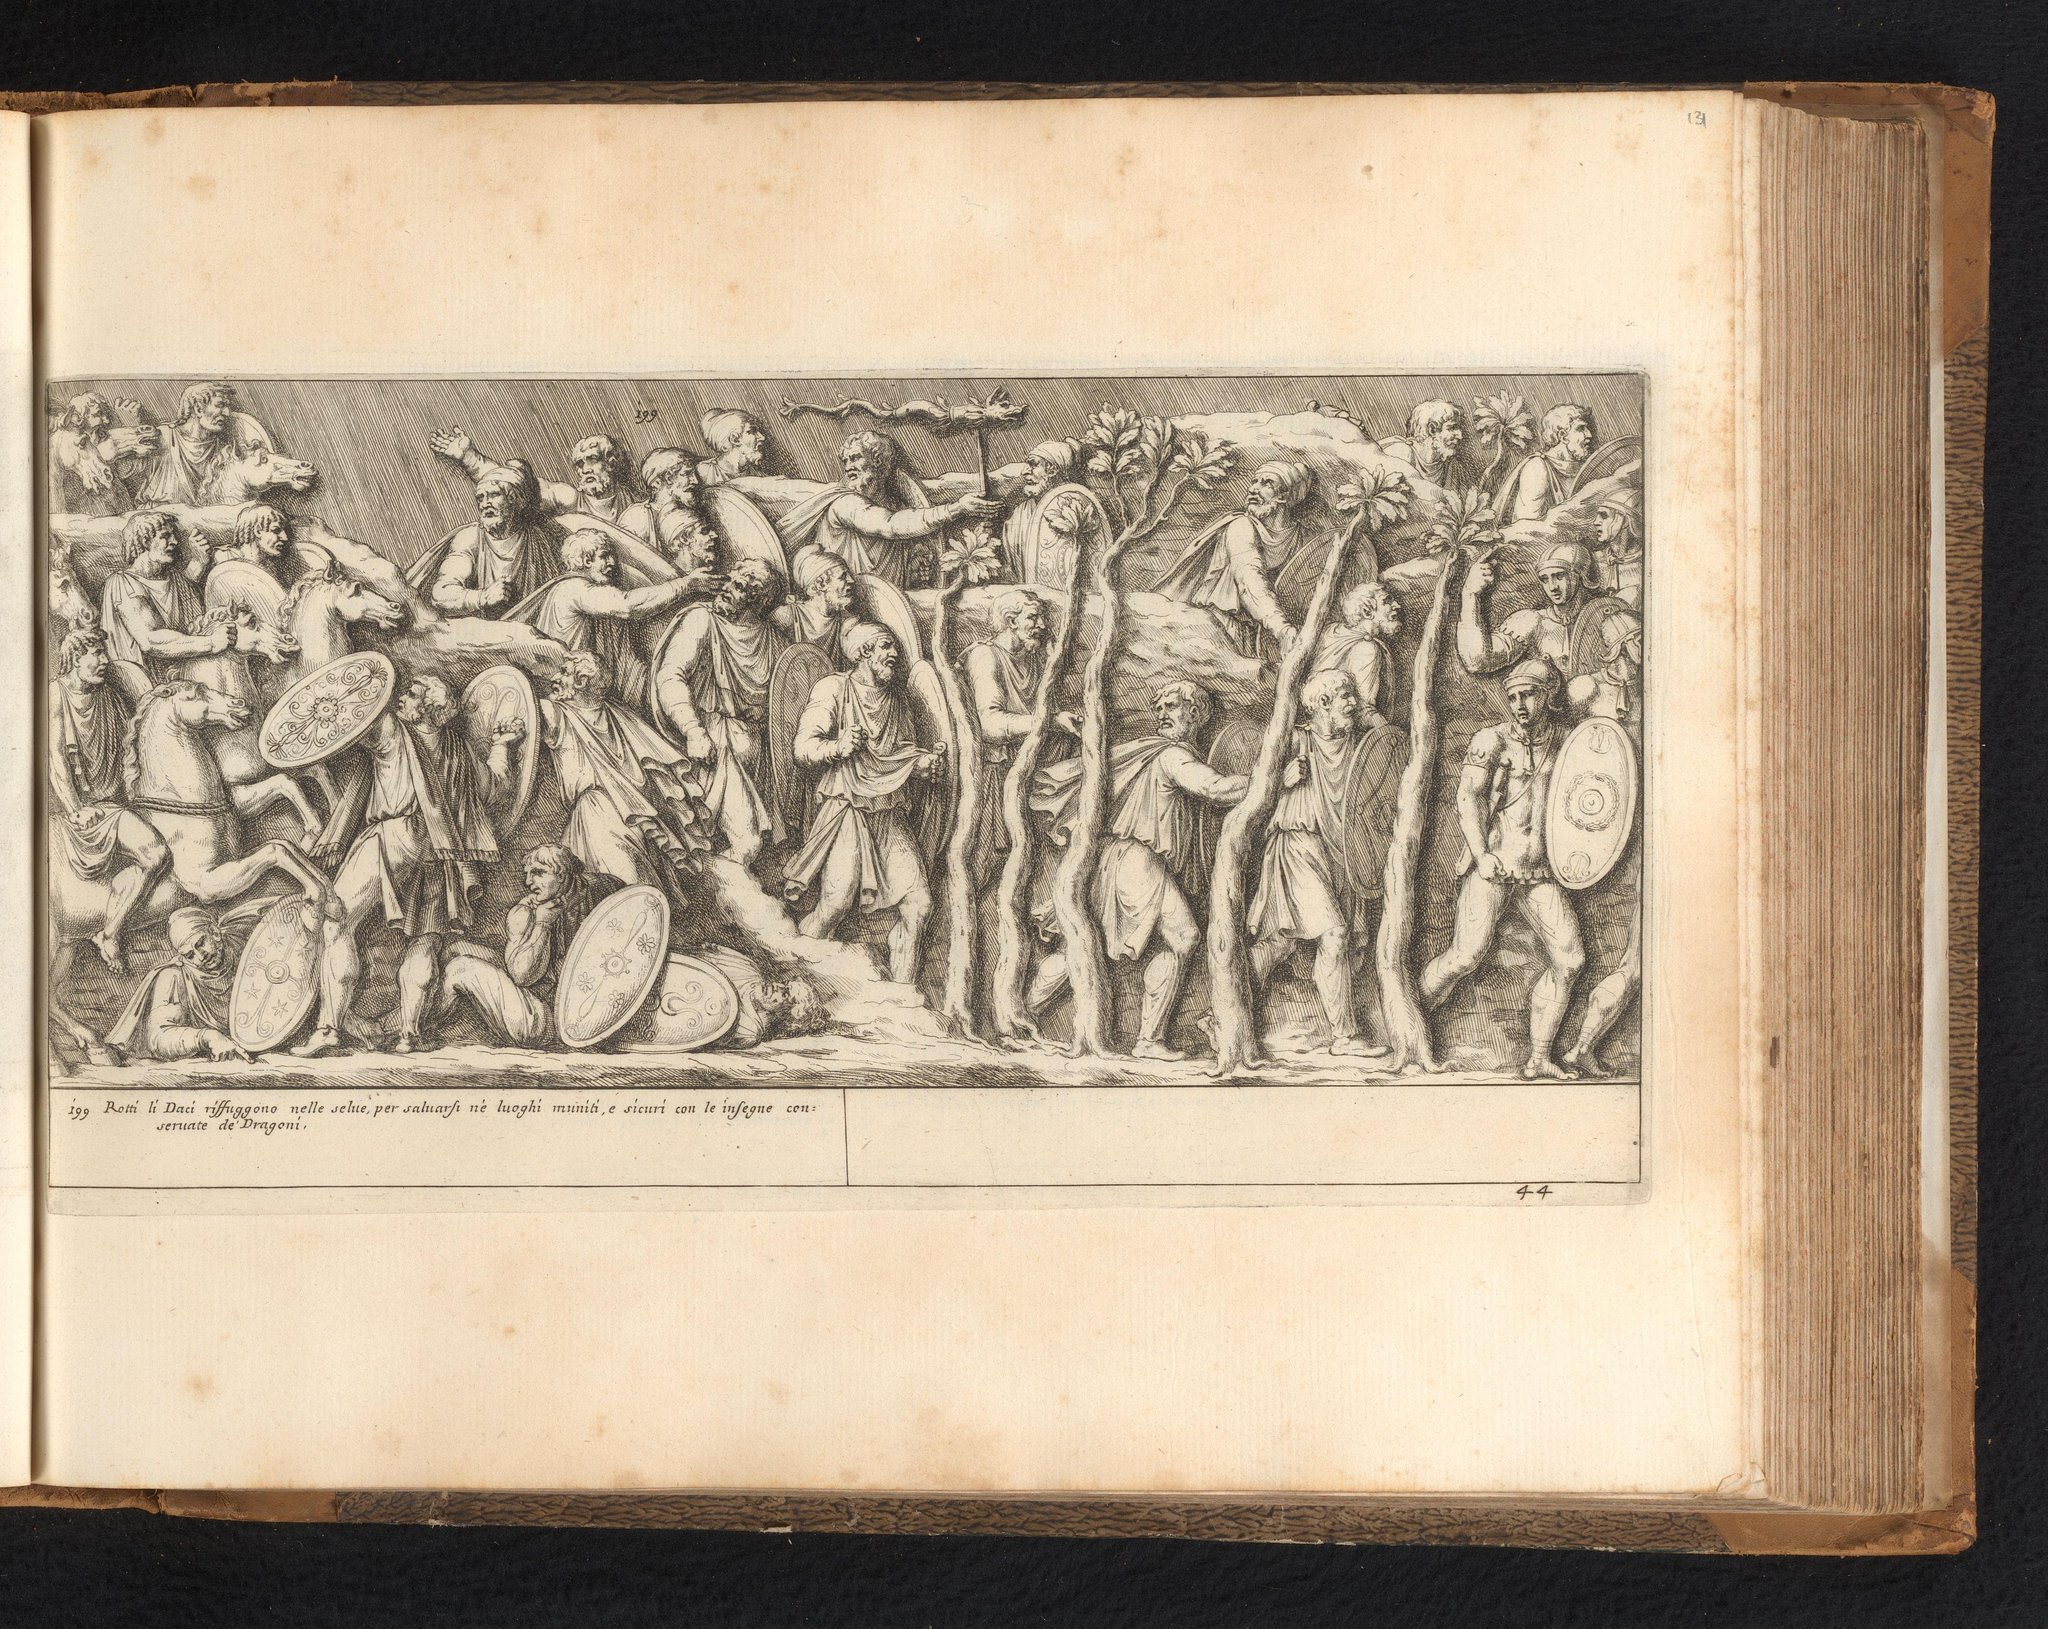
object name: album leaf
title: Detail van het fries op de Zuil van Trajanus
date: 1637-1691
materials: paper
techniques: etching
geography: vatican city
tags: triumphal column with helical friezes, piece of sculpture, reproduction of a piece of sculpture, the soldier; the soldier's life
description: Detail van het spiraalvormige gebeeldhouwde fries op de Zuil van Trajanus. Het fries toont de oorlogen tussen de Romeinen en de Daciërs. Verklarende nummers in de ondermarge. Prent maakt deel uit van een album.